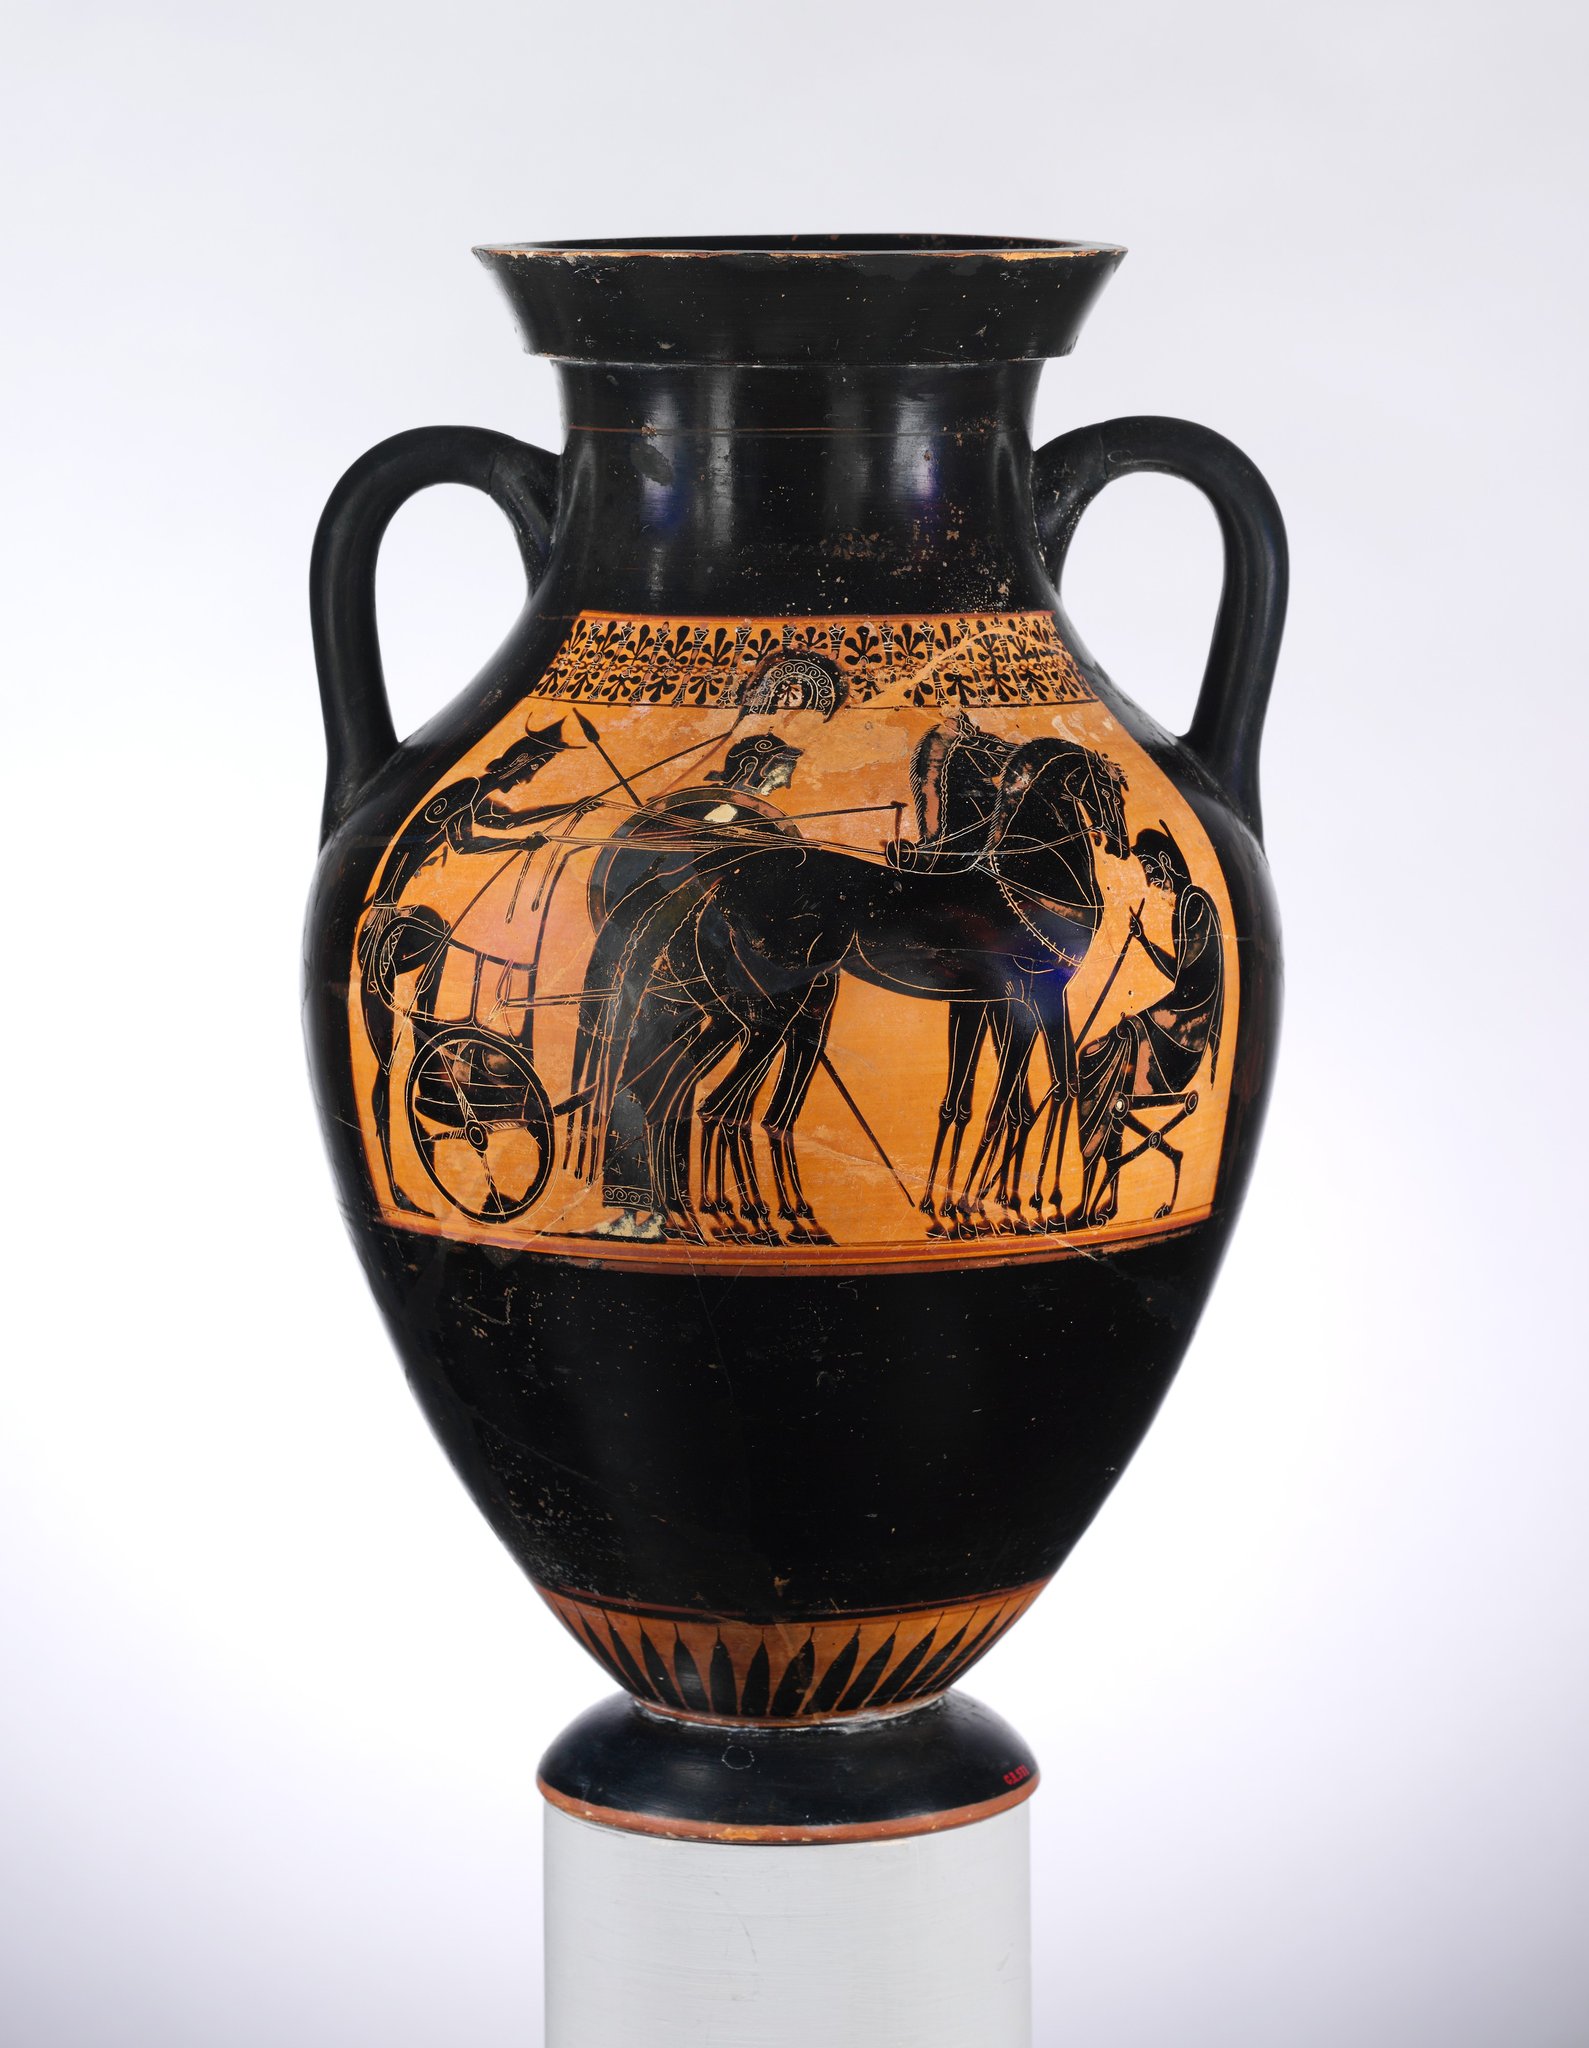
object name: amphora, type b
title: Terracotta amphora (jar)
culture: greek, attic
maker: lysippides painter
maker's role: artist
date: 530 BCE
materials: terracotta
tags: men,horses,chariots